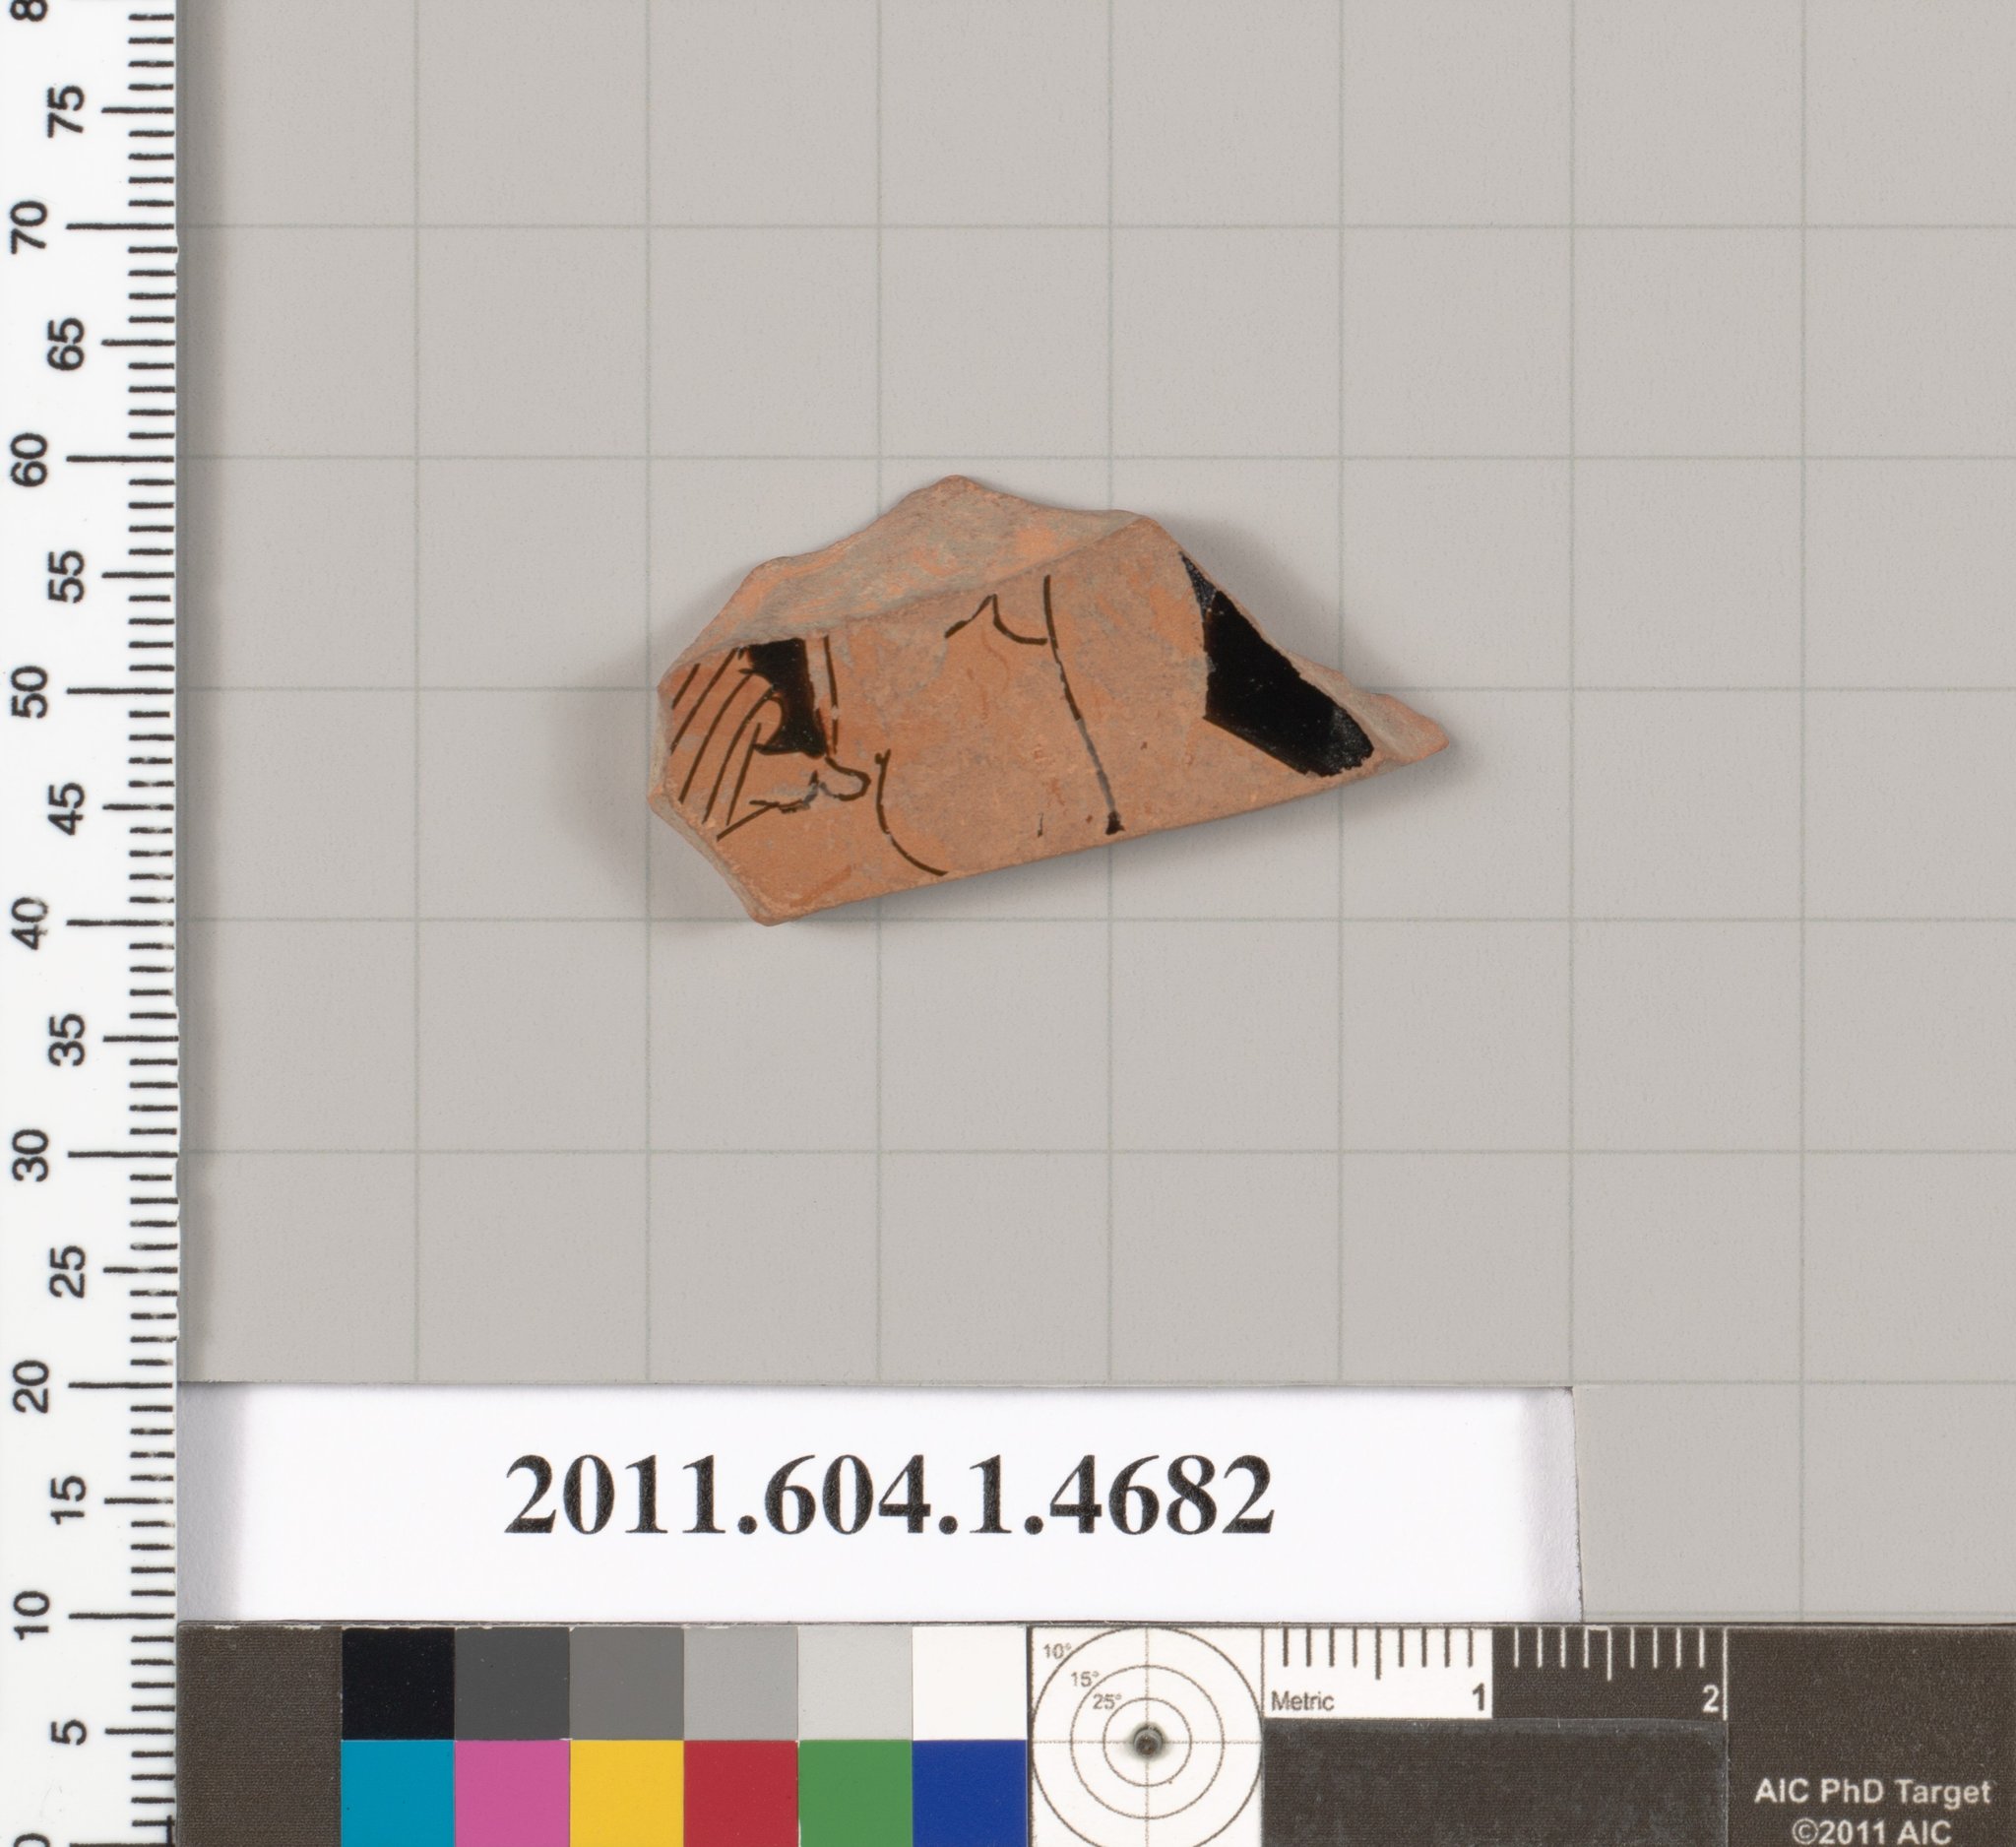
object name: kylix fragment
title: Terracotta fragment of a kylix (drinking cup)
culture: greek, attic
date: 480-470 BCE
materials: terracotta